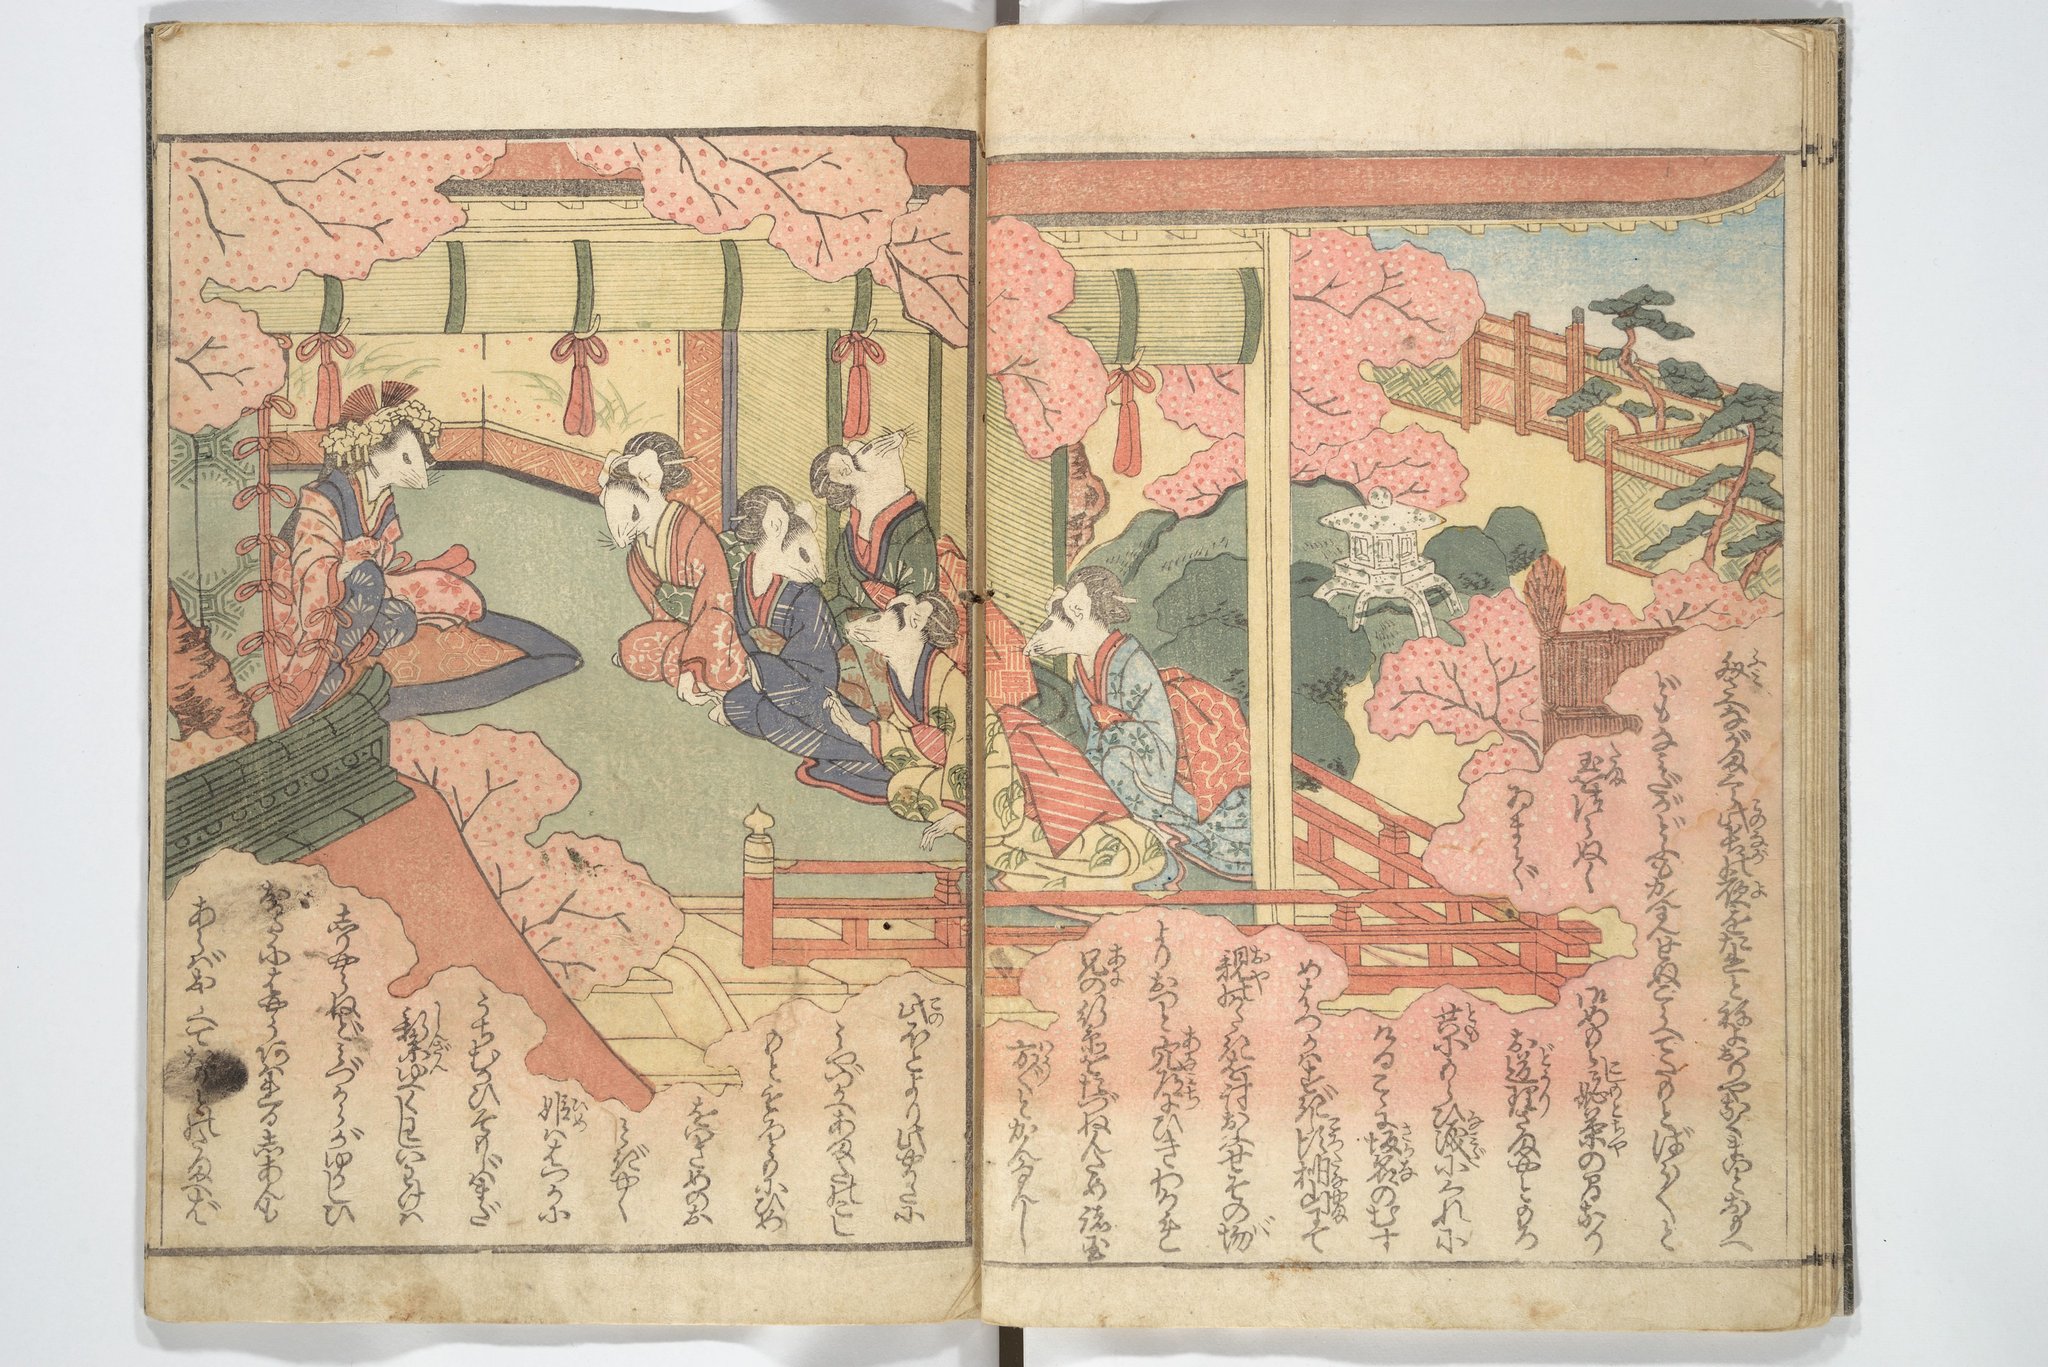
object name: illustrated book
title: Stories of a Fortunate Rat (Komochi nezumi hana no yamauba) 持子鼠花山姥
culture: japanese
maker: akatsuki no kanenari 暁鐘成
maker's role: artist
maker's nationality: japanese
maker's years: 1793-1861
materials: ink, paper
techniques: woodblock print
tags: human figures,mice